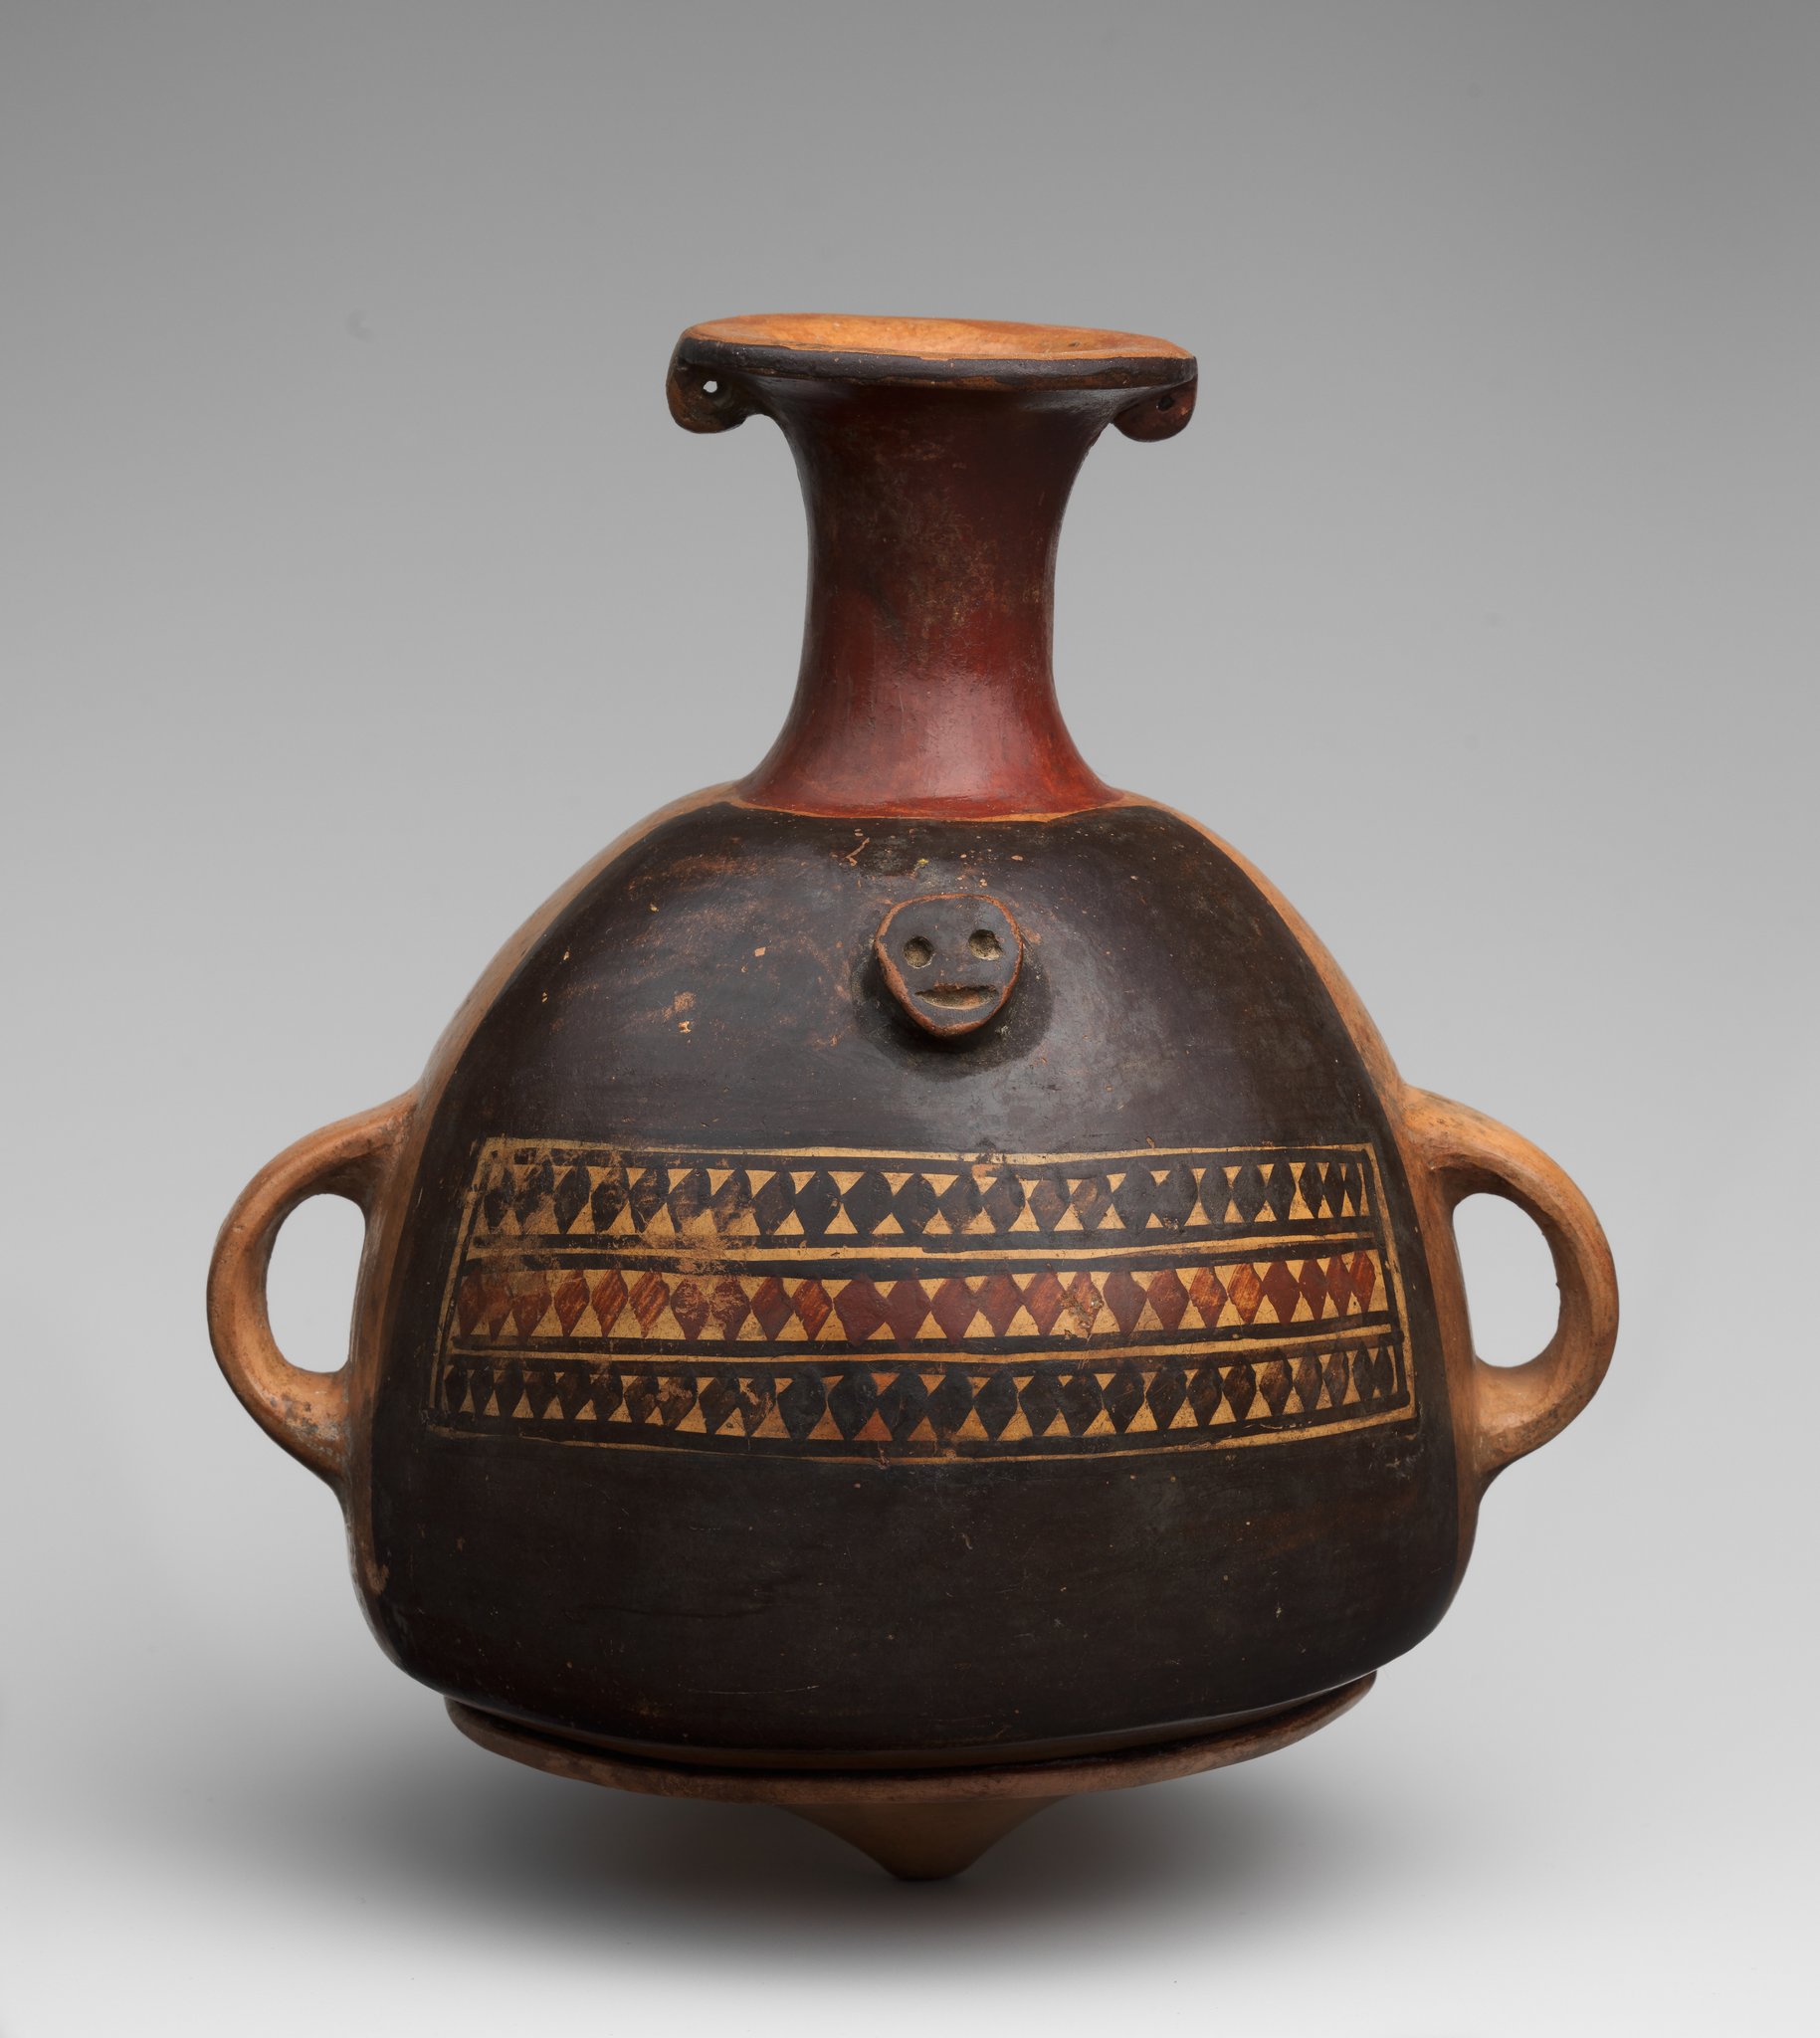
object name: bottle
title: Urpu (jar)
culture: inca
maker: inca artist(s)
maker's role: artist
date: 1400-1535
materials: ceramic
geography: peru